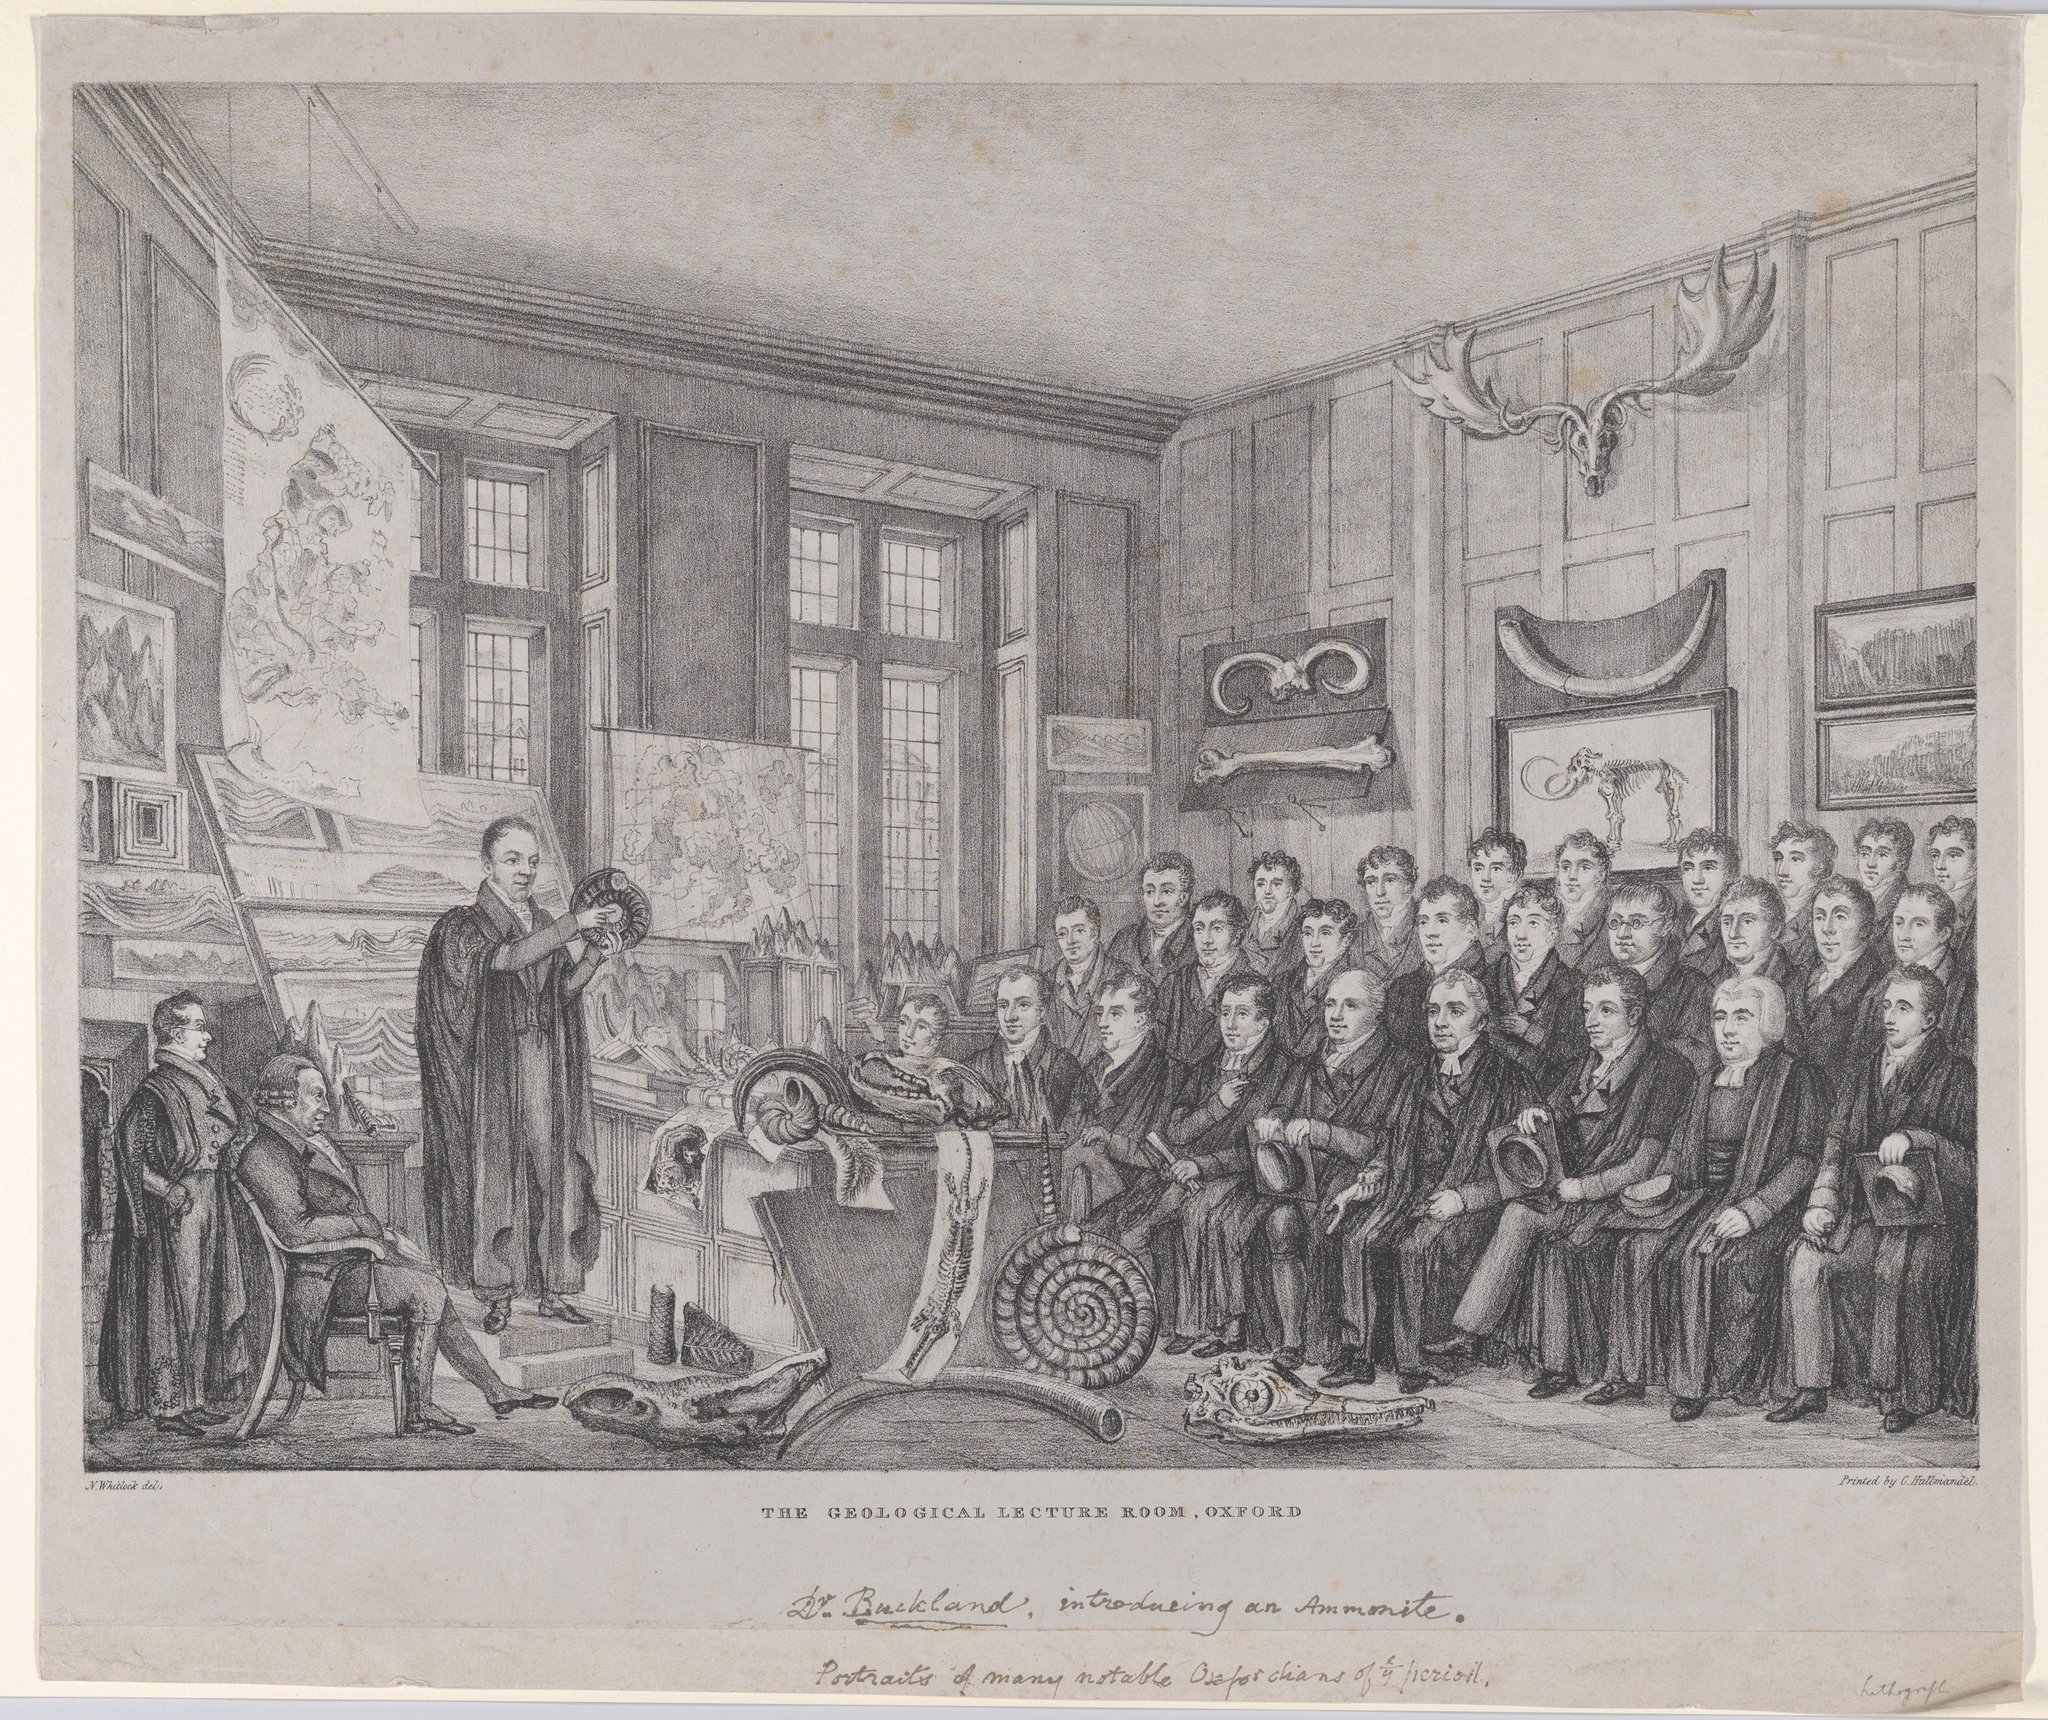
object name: print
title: The Geological Lecture Room, Oxford: Dr. William Buckland Lecturing on February 15, 1823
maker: nathaniel whittock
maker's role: artist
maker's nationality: british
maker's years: 1791-1860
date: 1823-1830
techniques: lithograph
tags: interiors,men